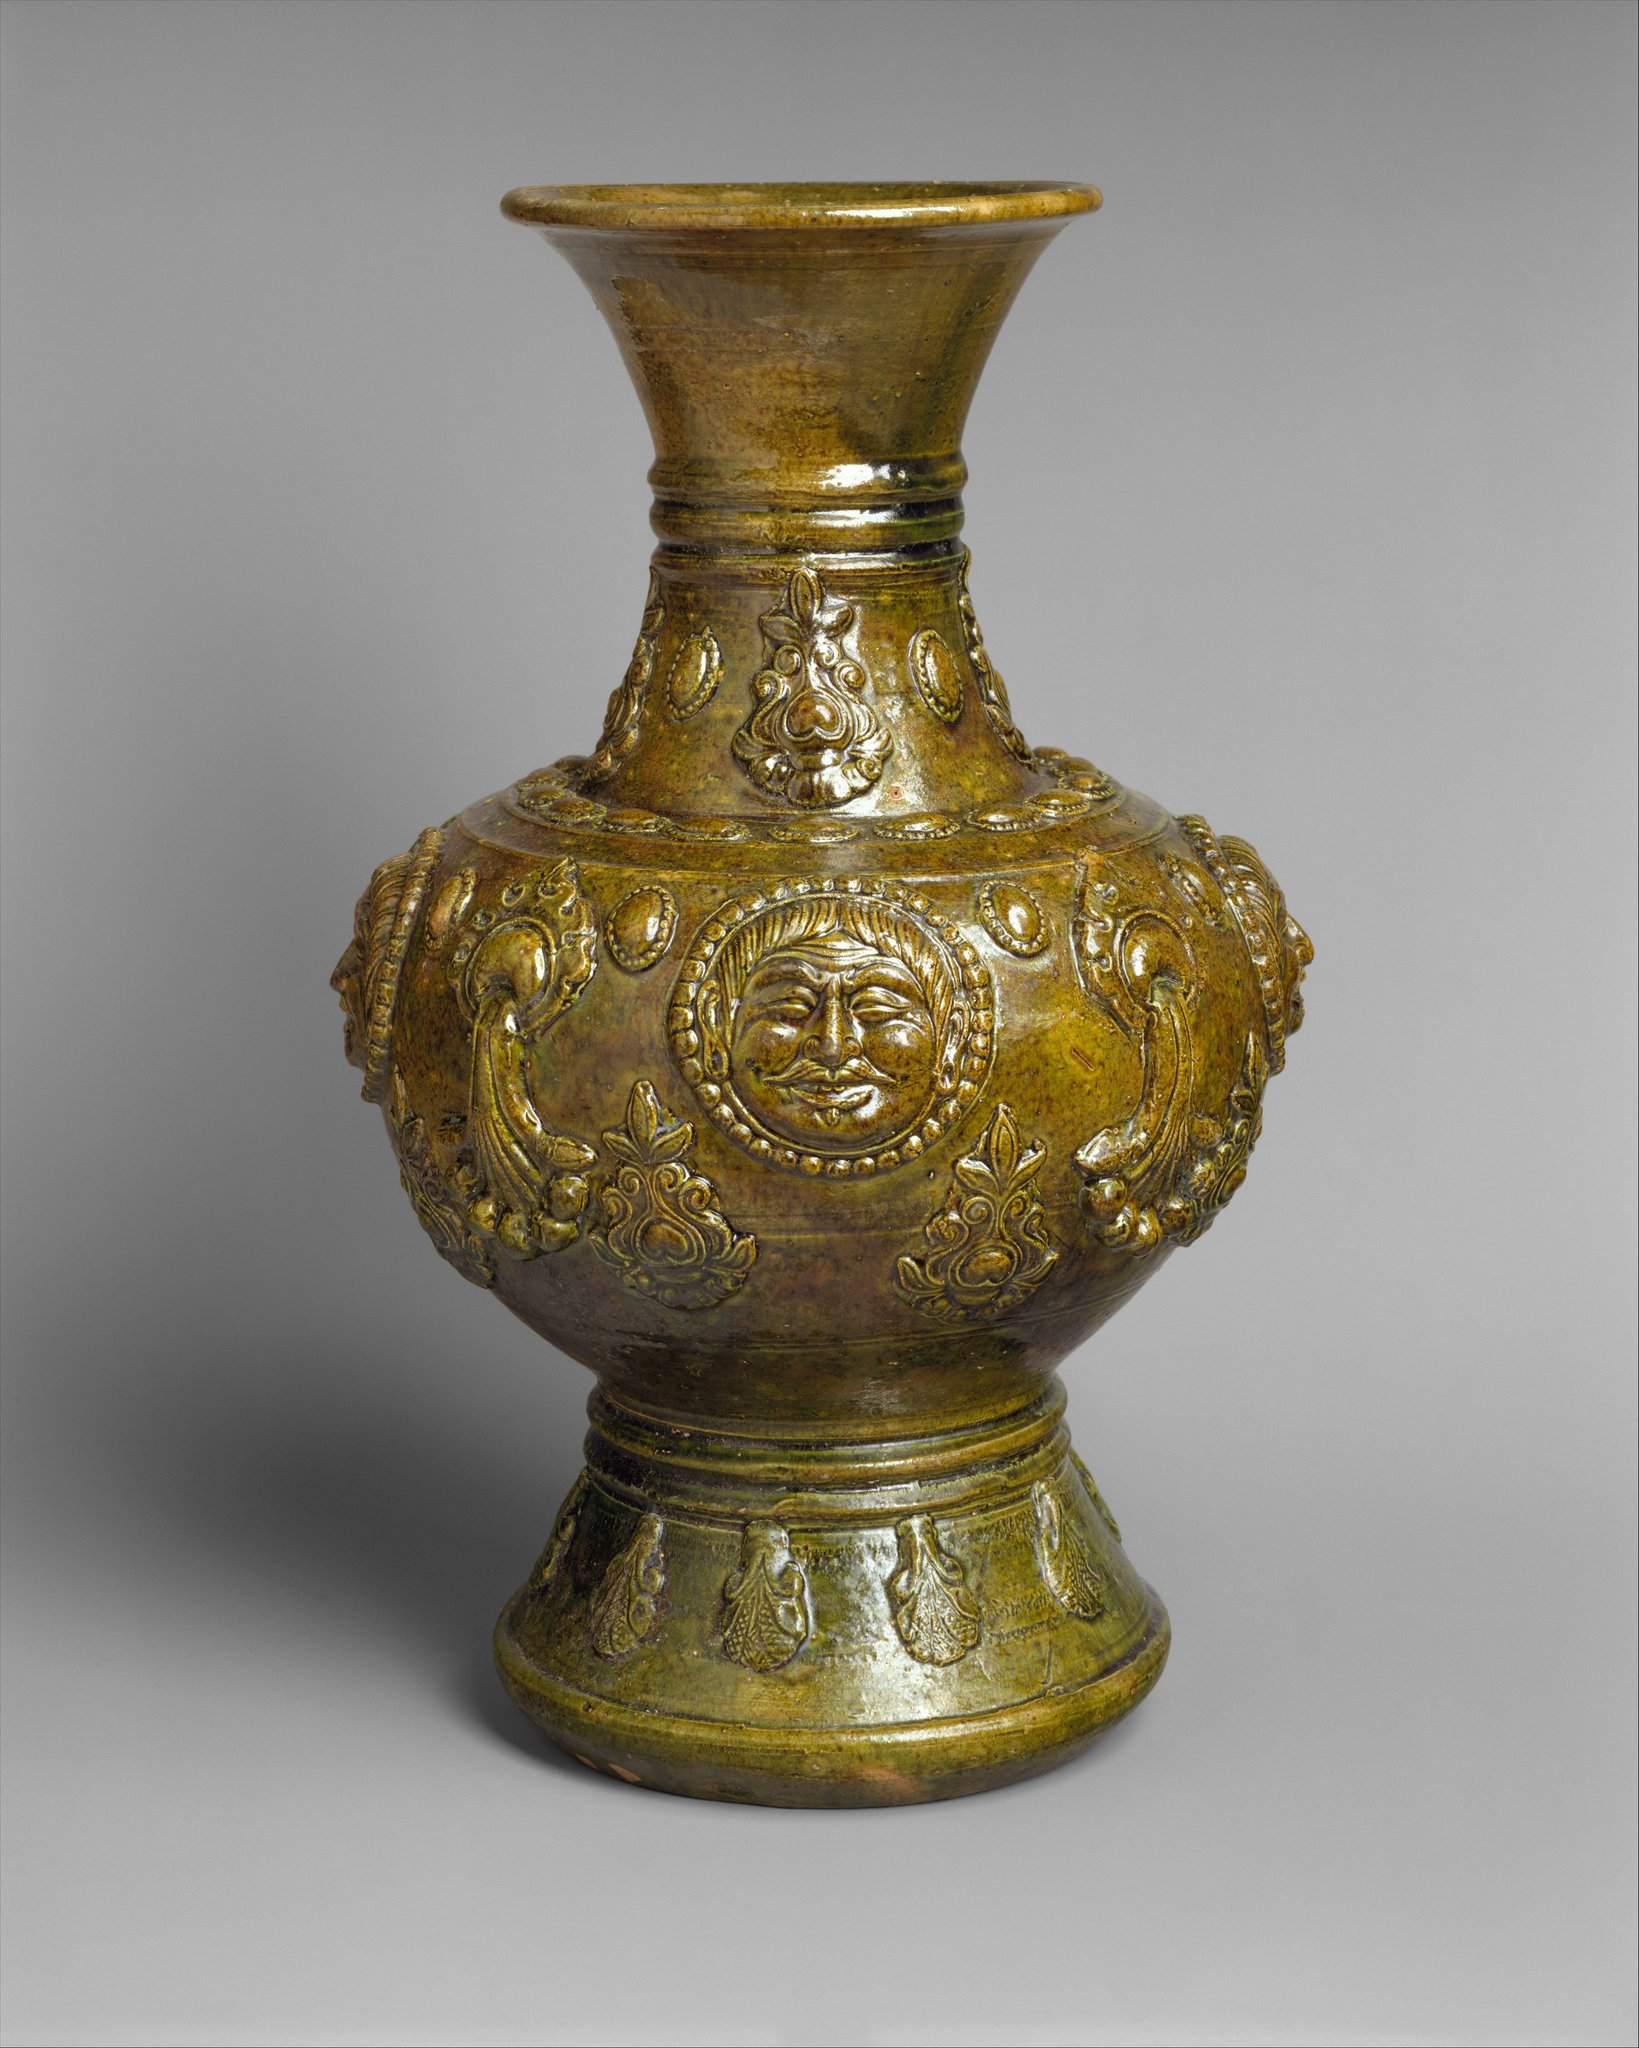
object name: jar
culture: chinese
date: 567-600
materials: earthenware, glaze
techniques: relief